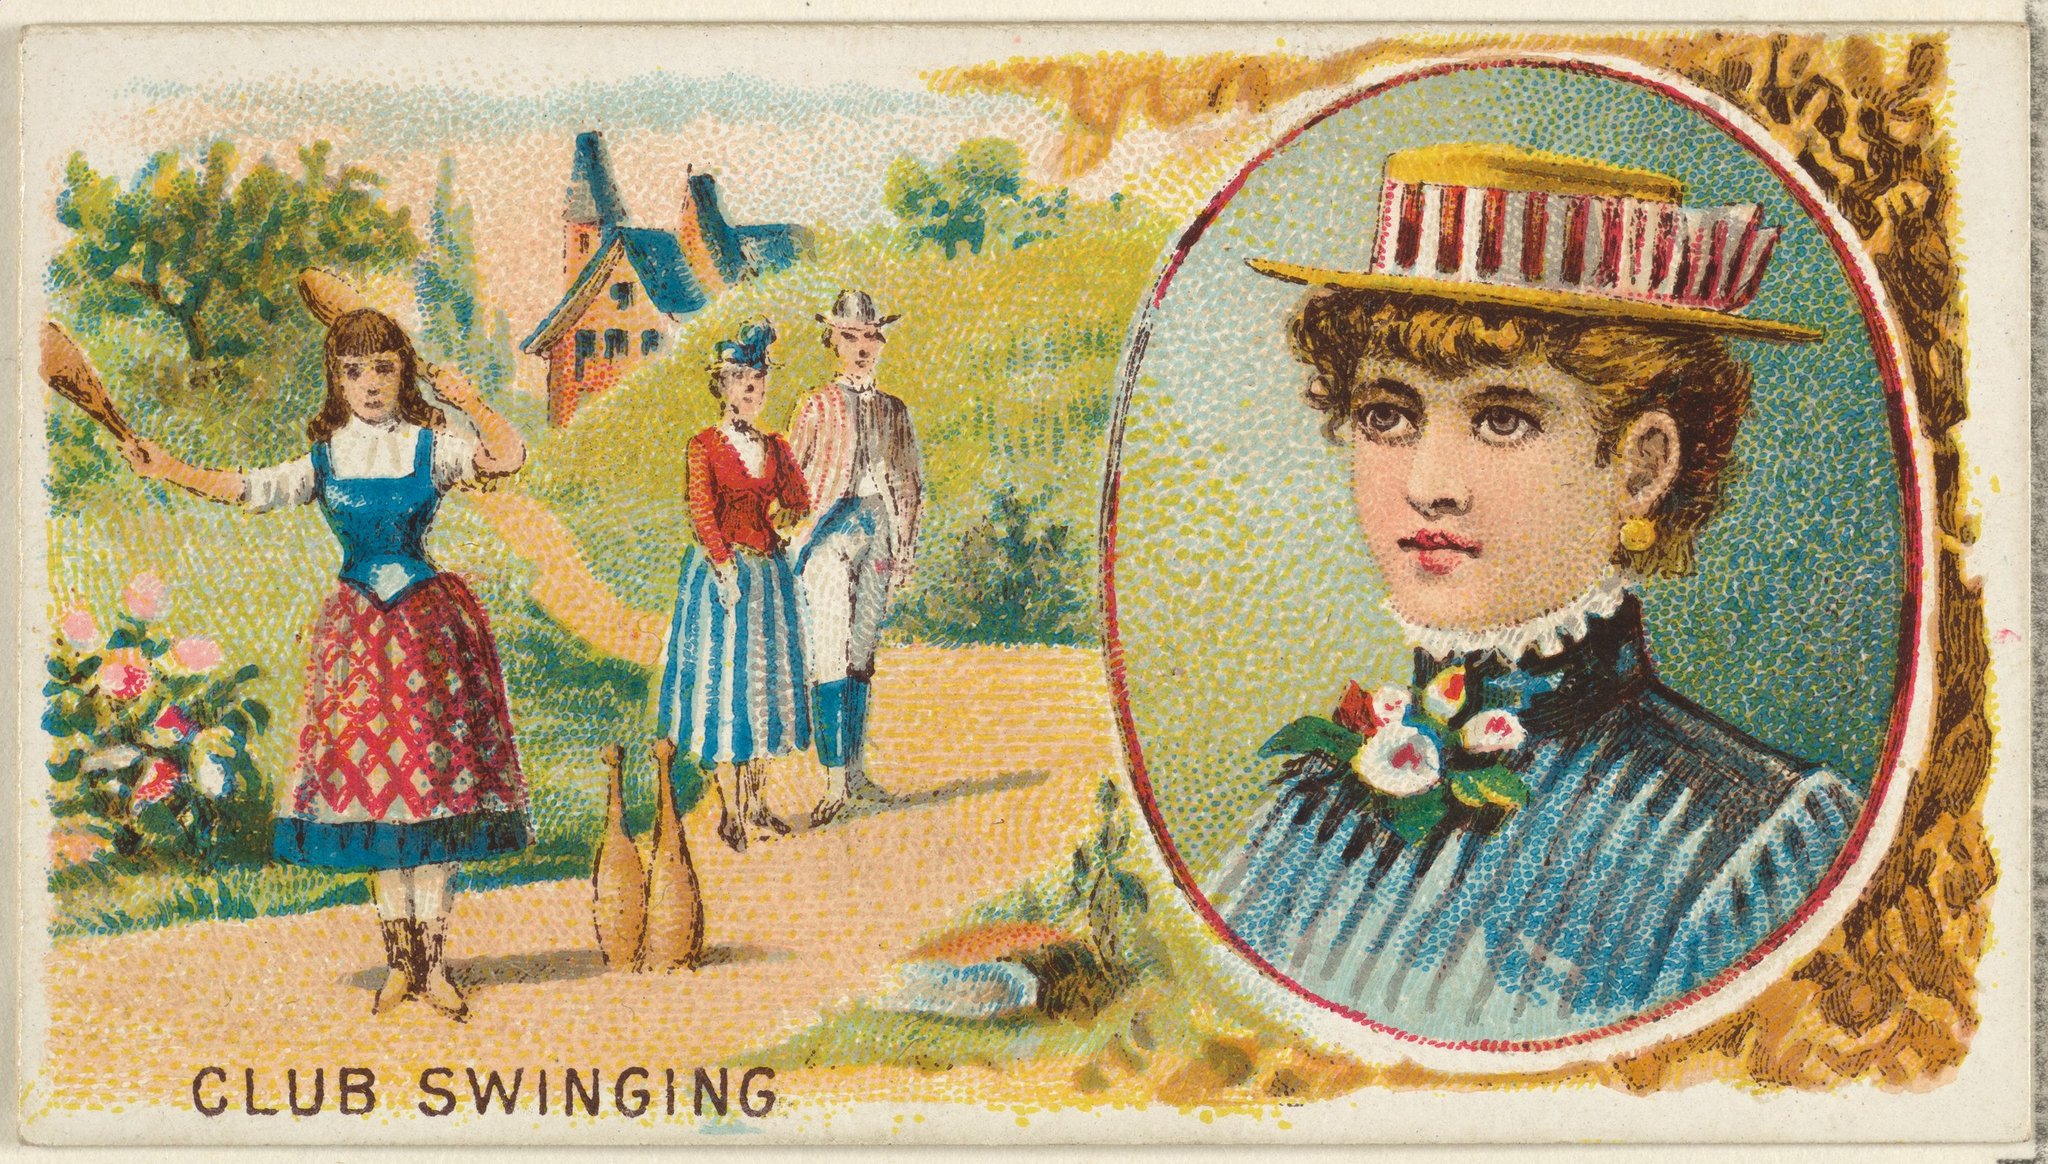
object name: print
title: Club Swinging, from the Games and Sports series (N165) for Old Judge Cigarettes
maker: goodwin & company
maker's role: publisher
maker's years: 1850-1950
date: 1889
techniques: color lithograph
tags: men,women